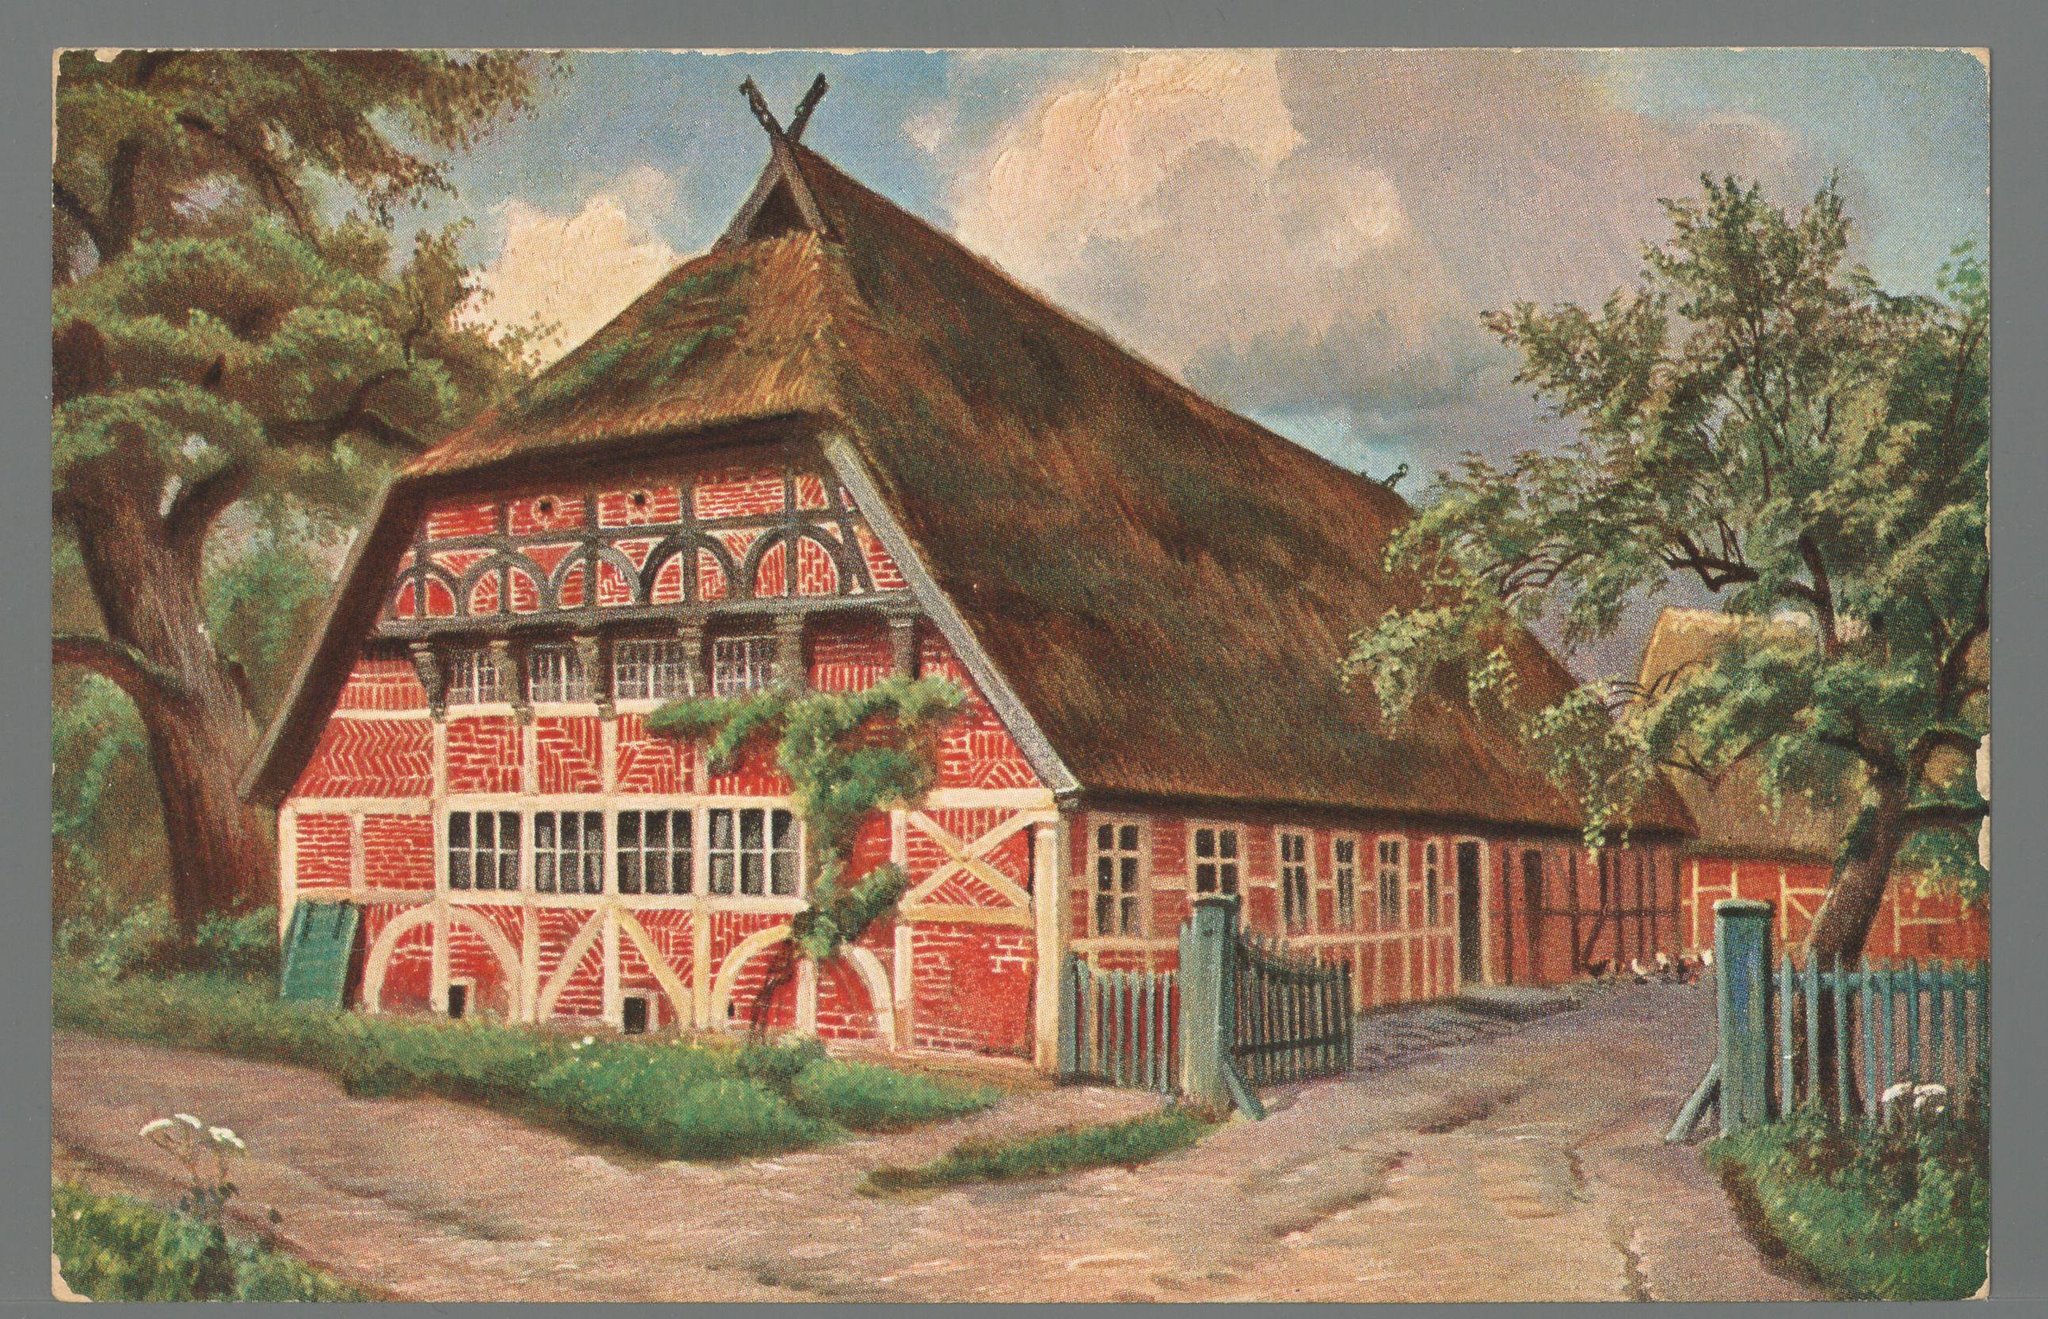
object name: ansichtkaart, prentbriefkaart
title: Friesisches Bauernhaus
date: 1905-1908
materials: cardboard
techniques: writing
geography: nuremberg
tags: farm (building)